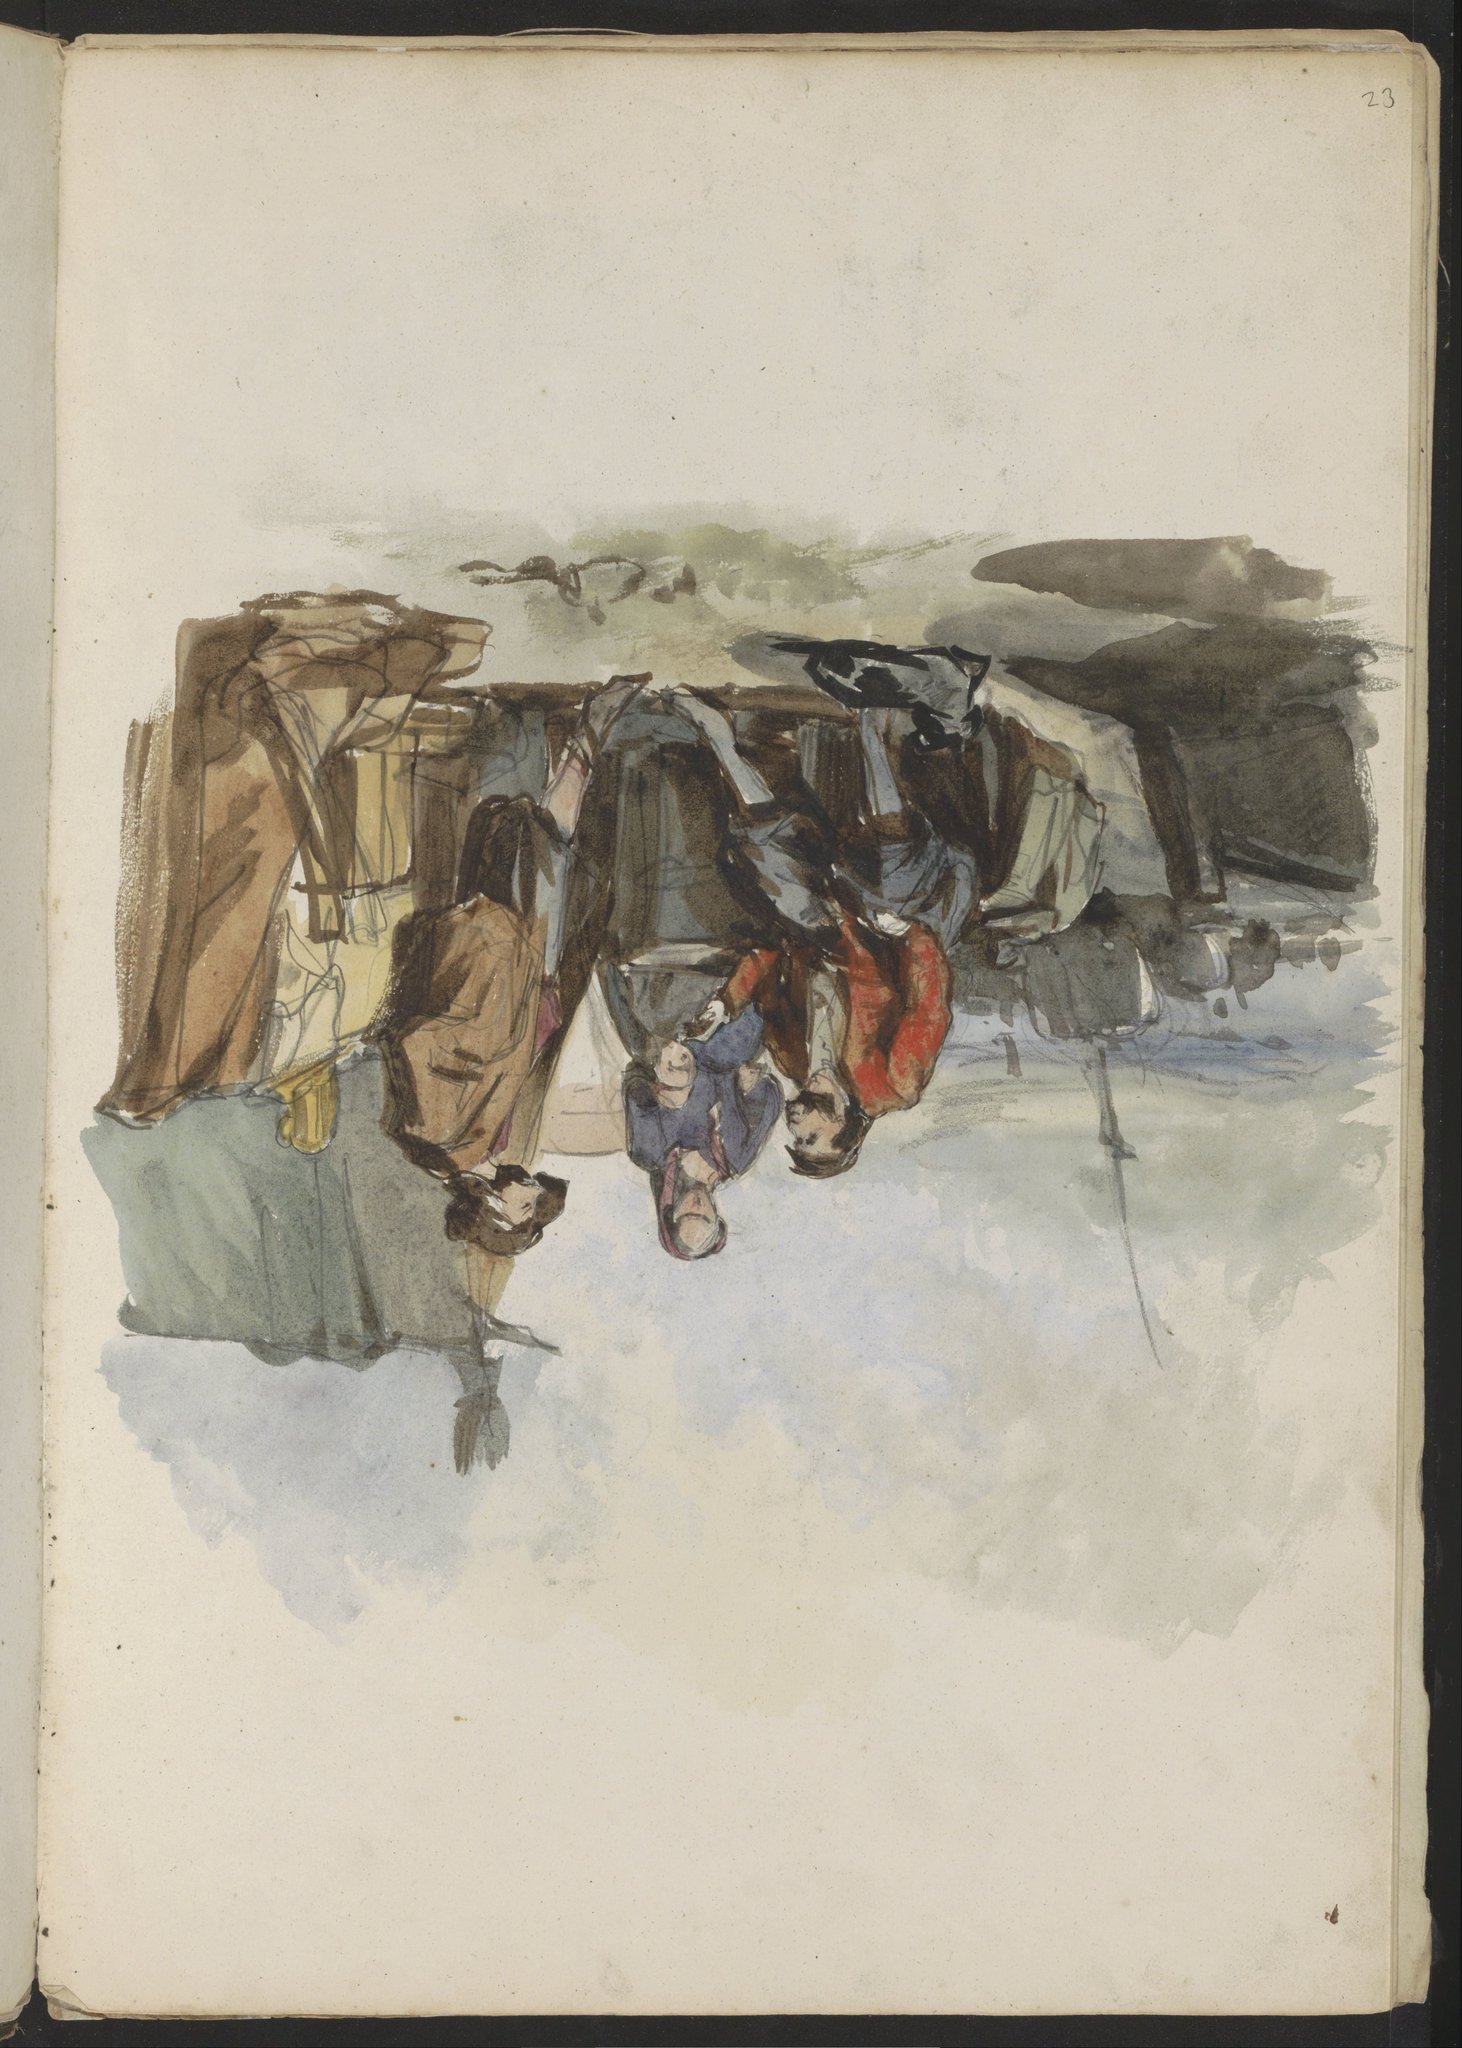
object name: sketchbook leaf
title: Groep figuren bij een kade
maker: johannes huybertus van hove bzn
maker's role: print maker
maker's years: 1827-1881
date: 1837-1881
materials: paper, pencil, watercolor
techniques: brush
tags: pier, quay, wharf (+ view ~ vehicle, ship, etc.)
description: Een zittende man steunt met zijn linkerelleboog op een ton en richt zich tot de overige figuren. Op de achtergrond de masten van zeilschepen. Blad 23 recto uit een schetsboek met 33 bladen en 10 losse tekeningen.